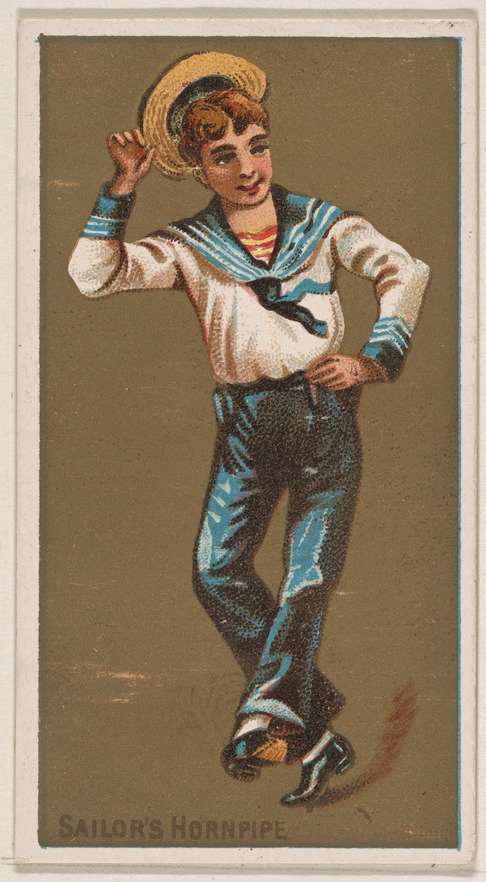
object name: print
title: Sailor's Hornpipe, from National Dances (N225, Type 1) issued by Kinney Bros.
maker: kinney brothers tobacco company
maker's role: publisher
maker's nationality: american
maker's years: 1869-2011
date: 1889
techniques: color lithograph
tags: women,dancing,dancers